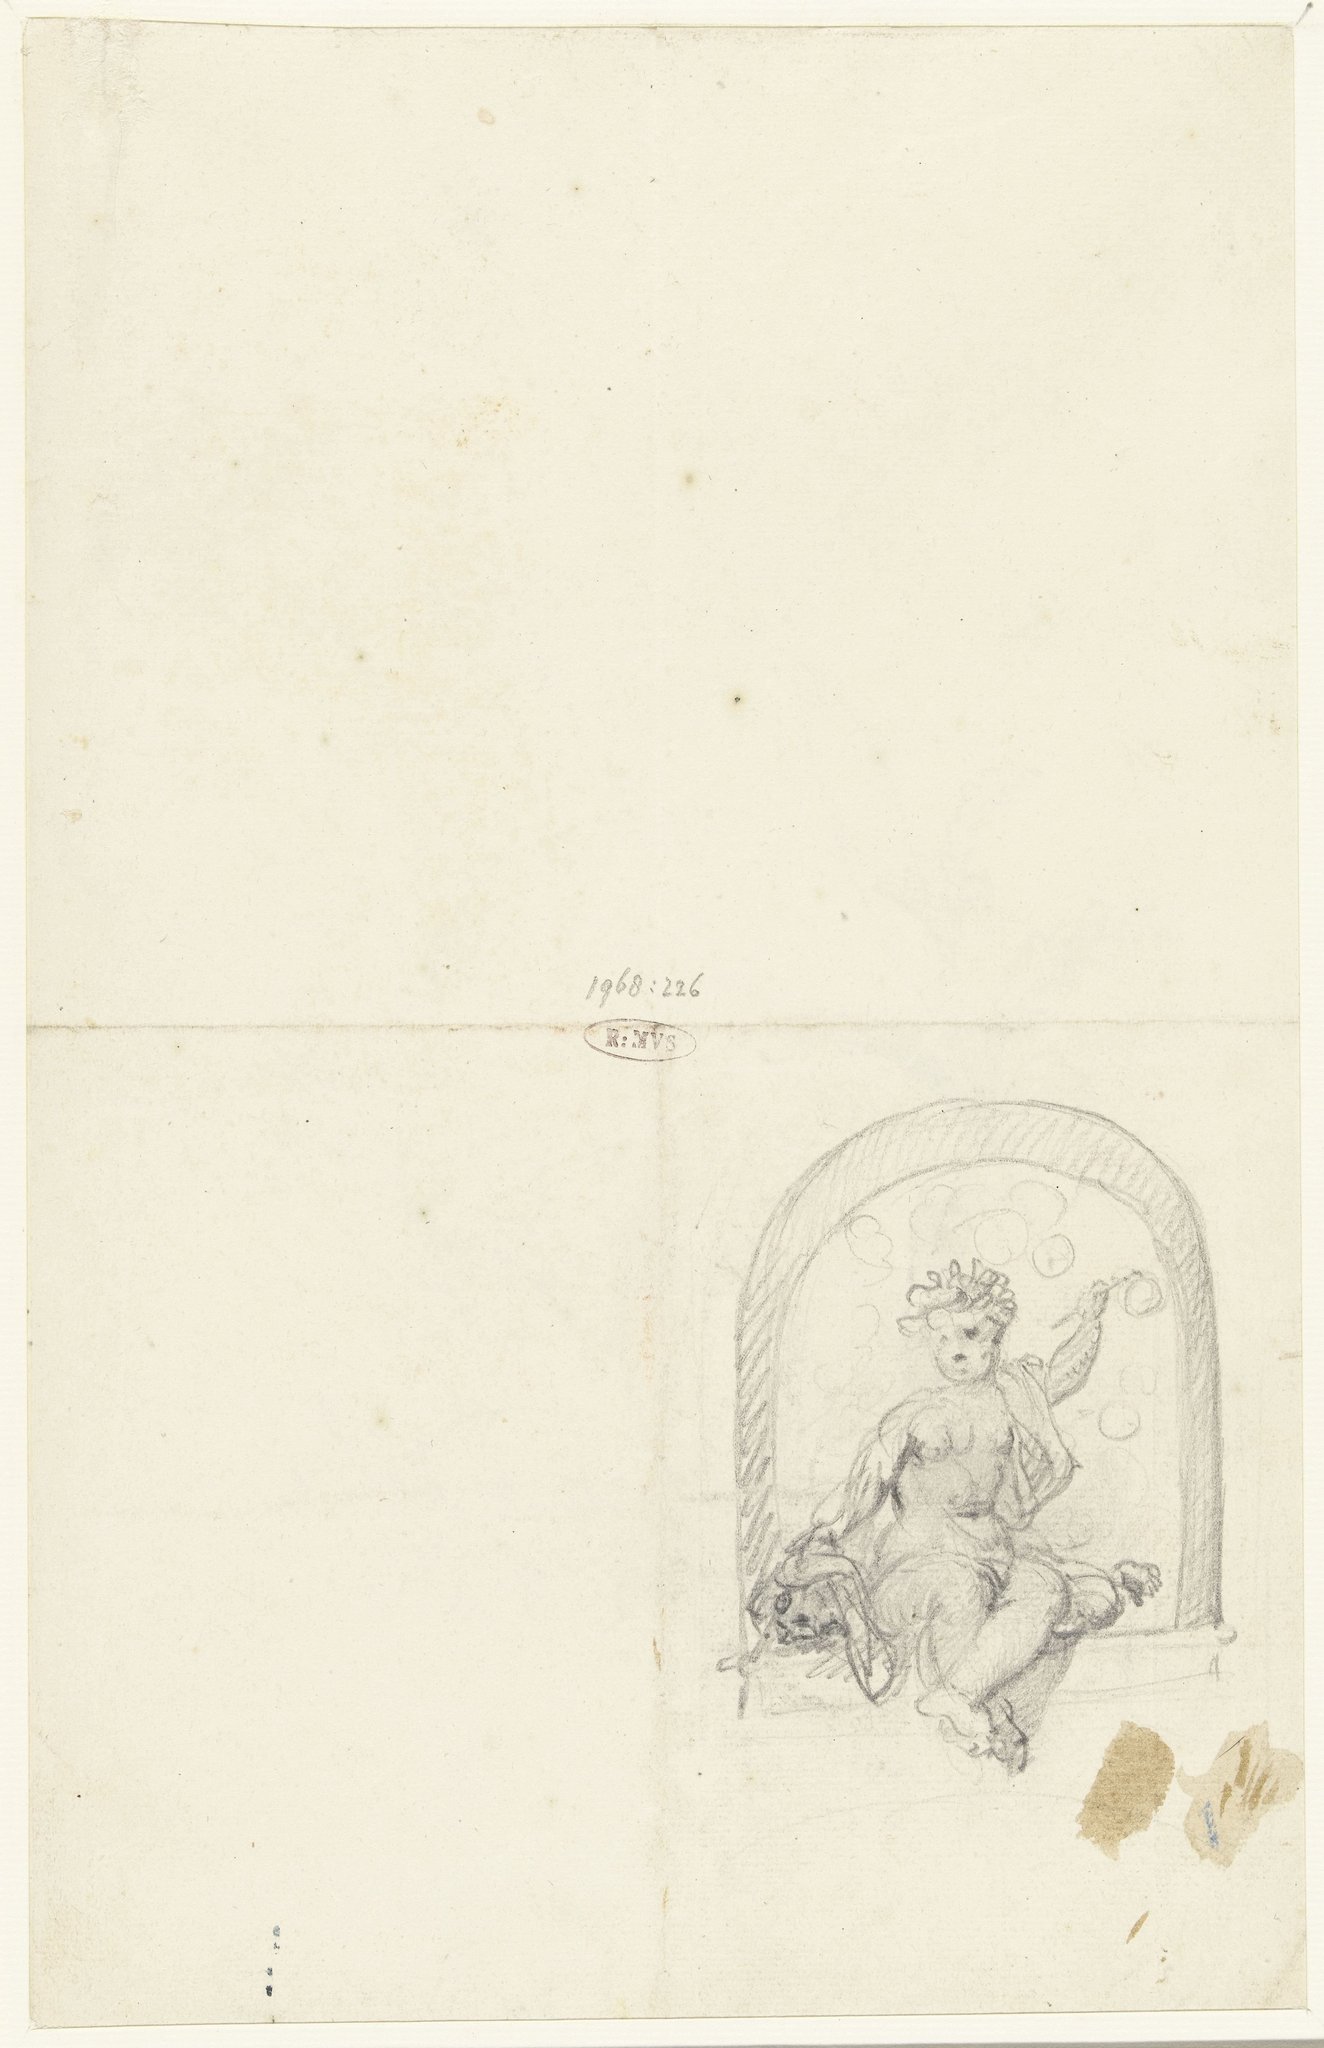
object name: drawing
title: Bellenblazend kind met schedel, zittend in een nis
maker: elias van nijmegen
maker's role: draughtsman, painter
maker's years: 1667-1755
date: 1677-1755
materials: paper, pencil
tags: (children or putti) blowing bubbles, 'homo bulla' ~ scene symbolizing 'vanitas'